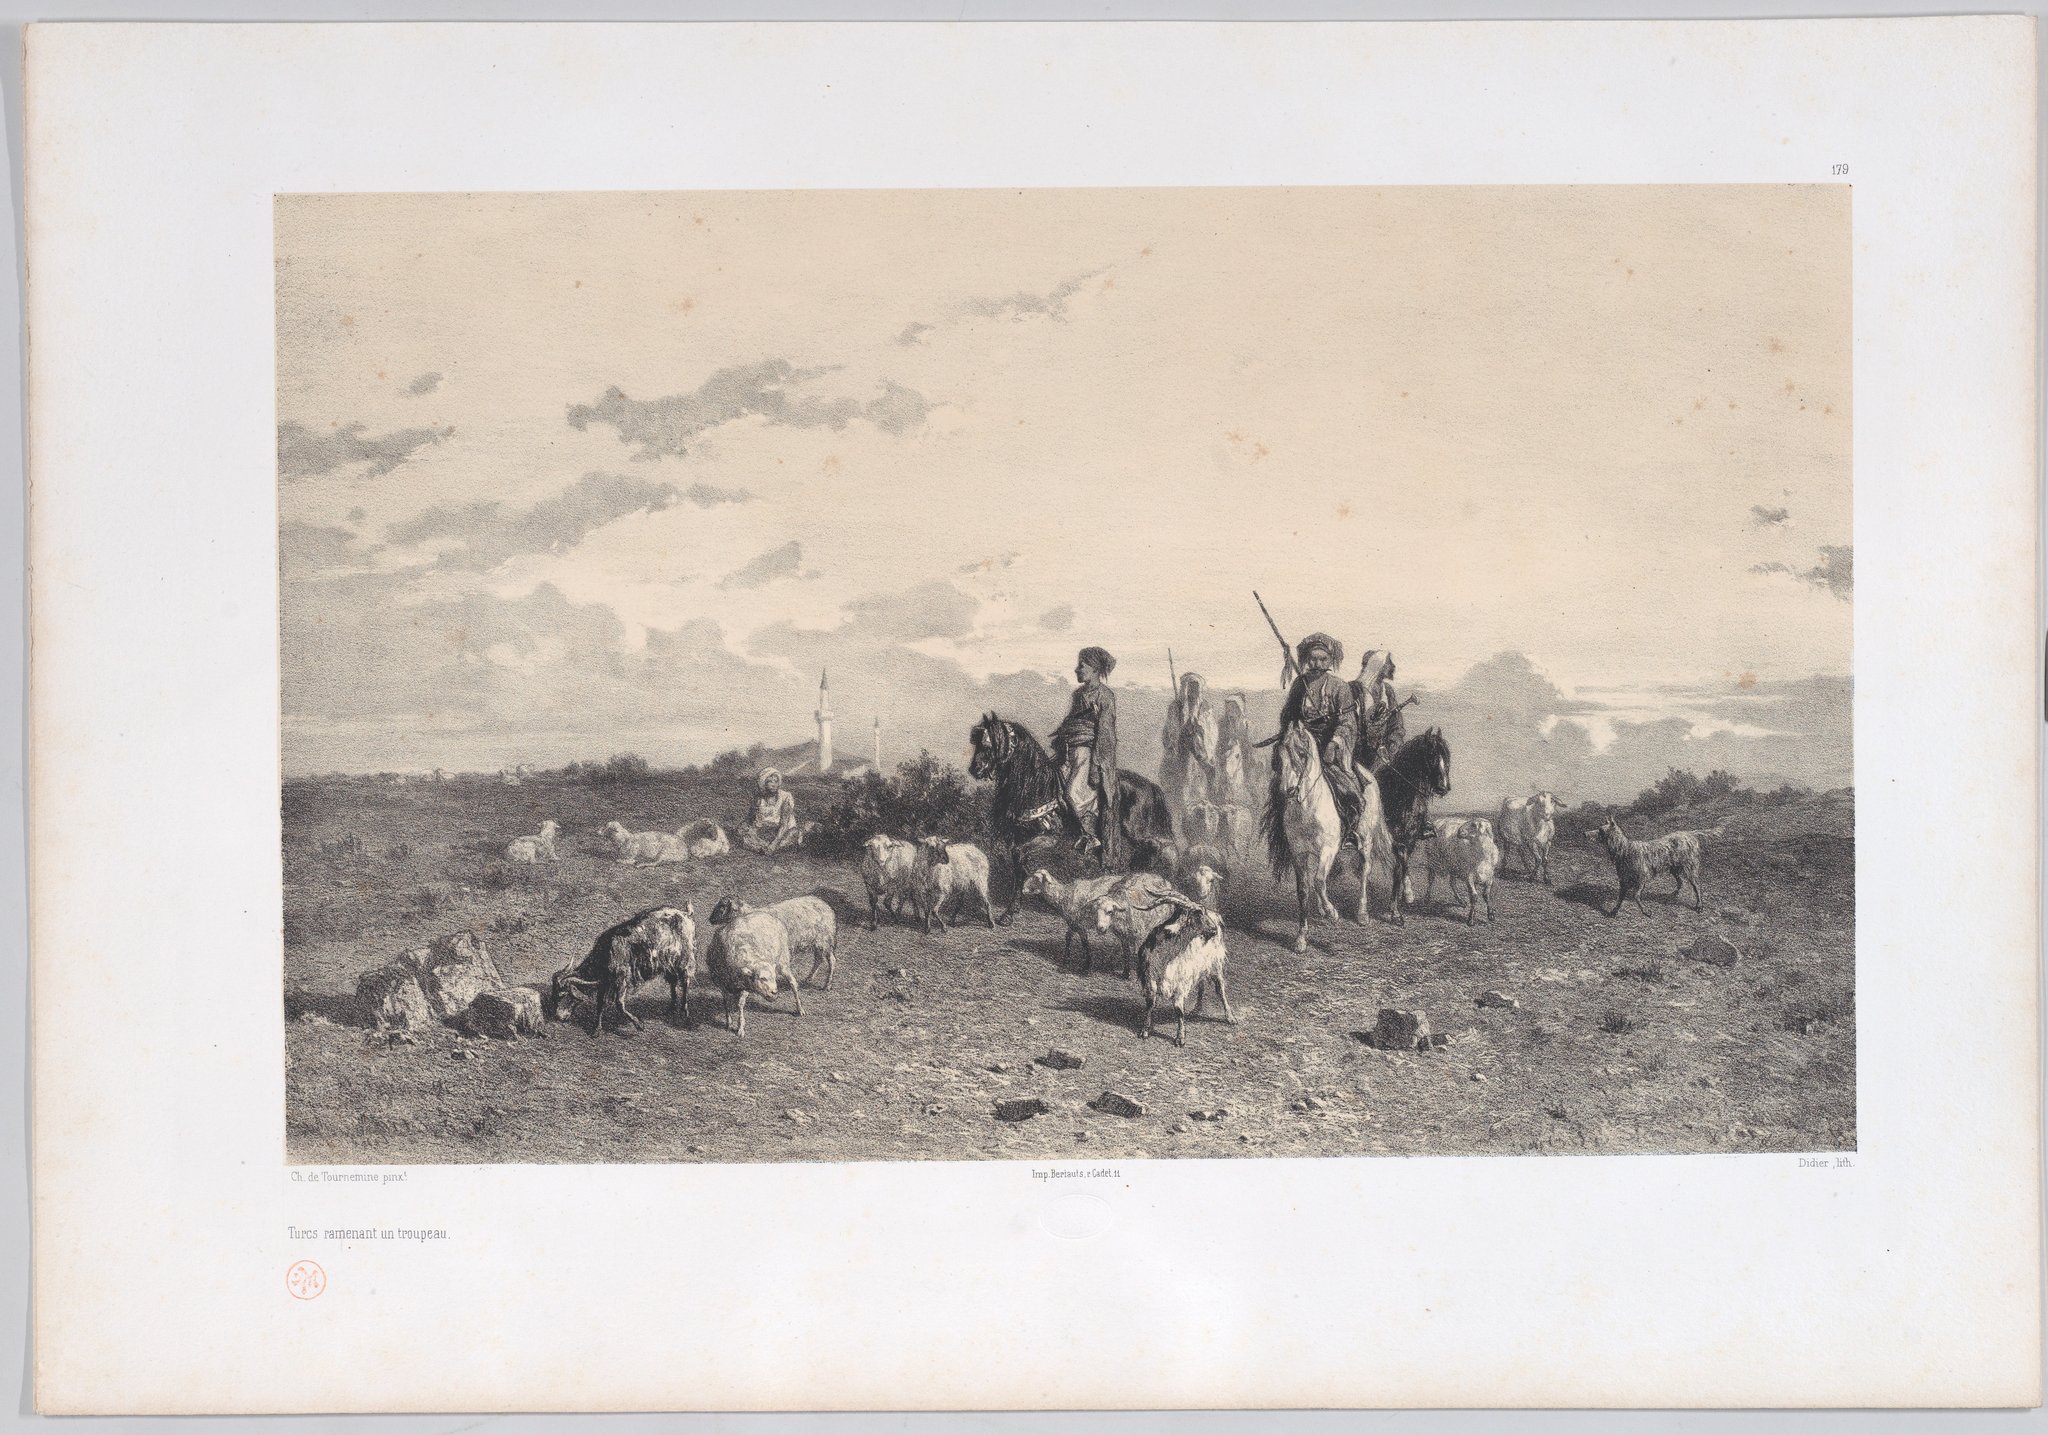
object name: print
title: Turcs ramenant un troupeau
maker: jules didier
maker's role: artist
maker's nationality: french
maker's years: 1831-1914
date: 1850-1914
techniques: lithograph